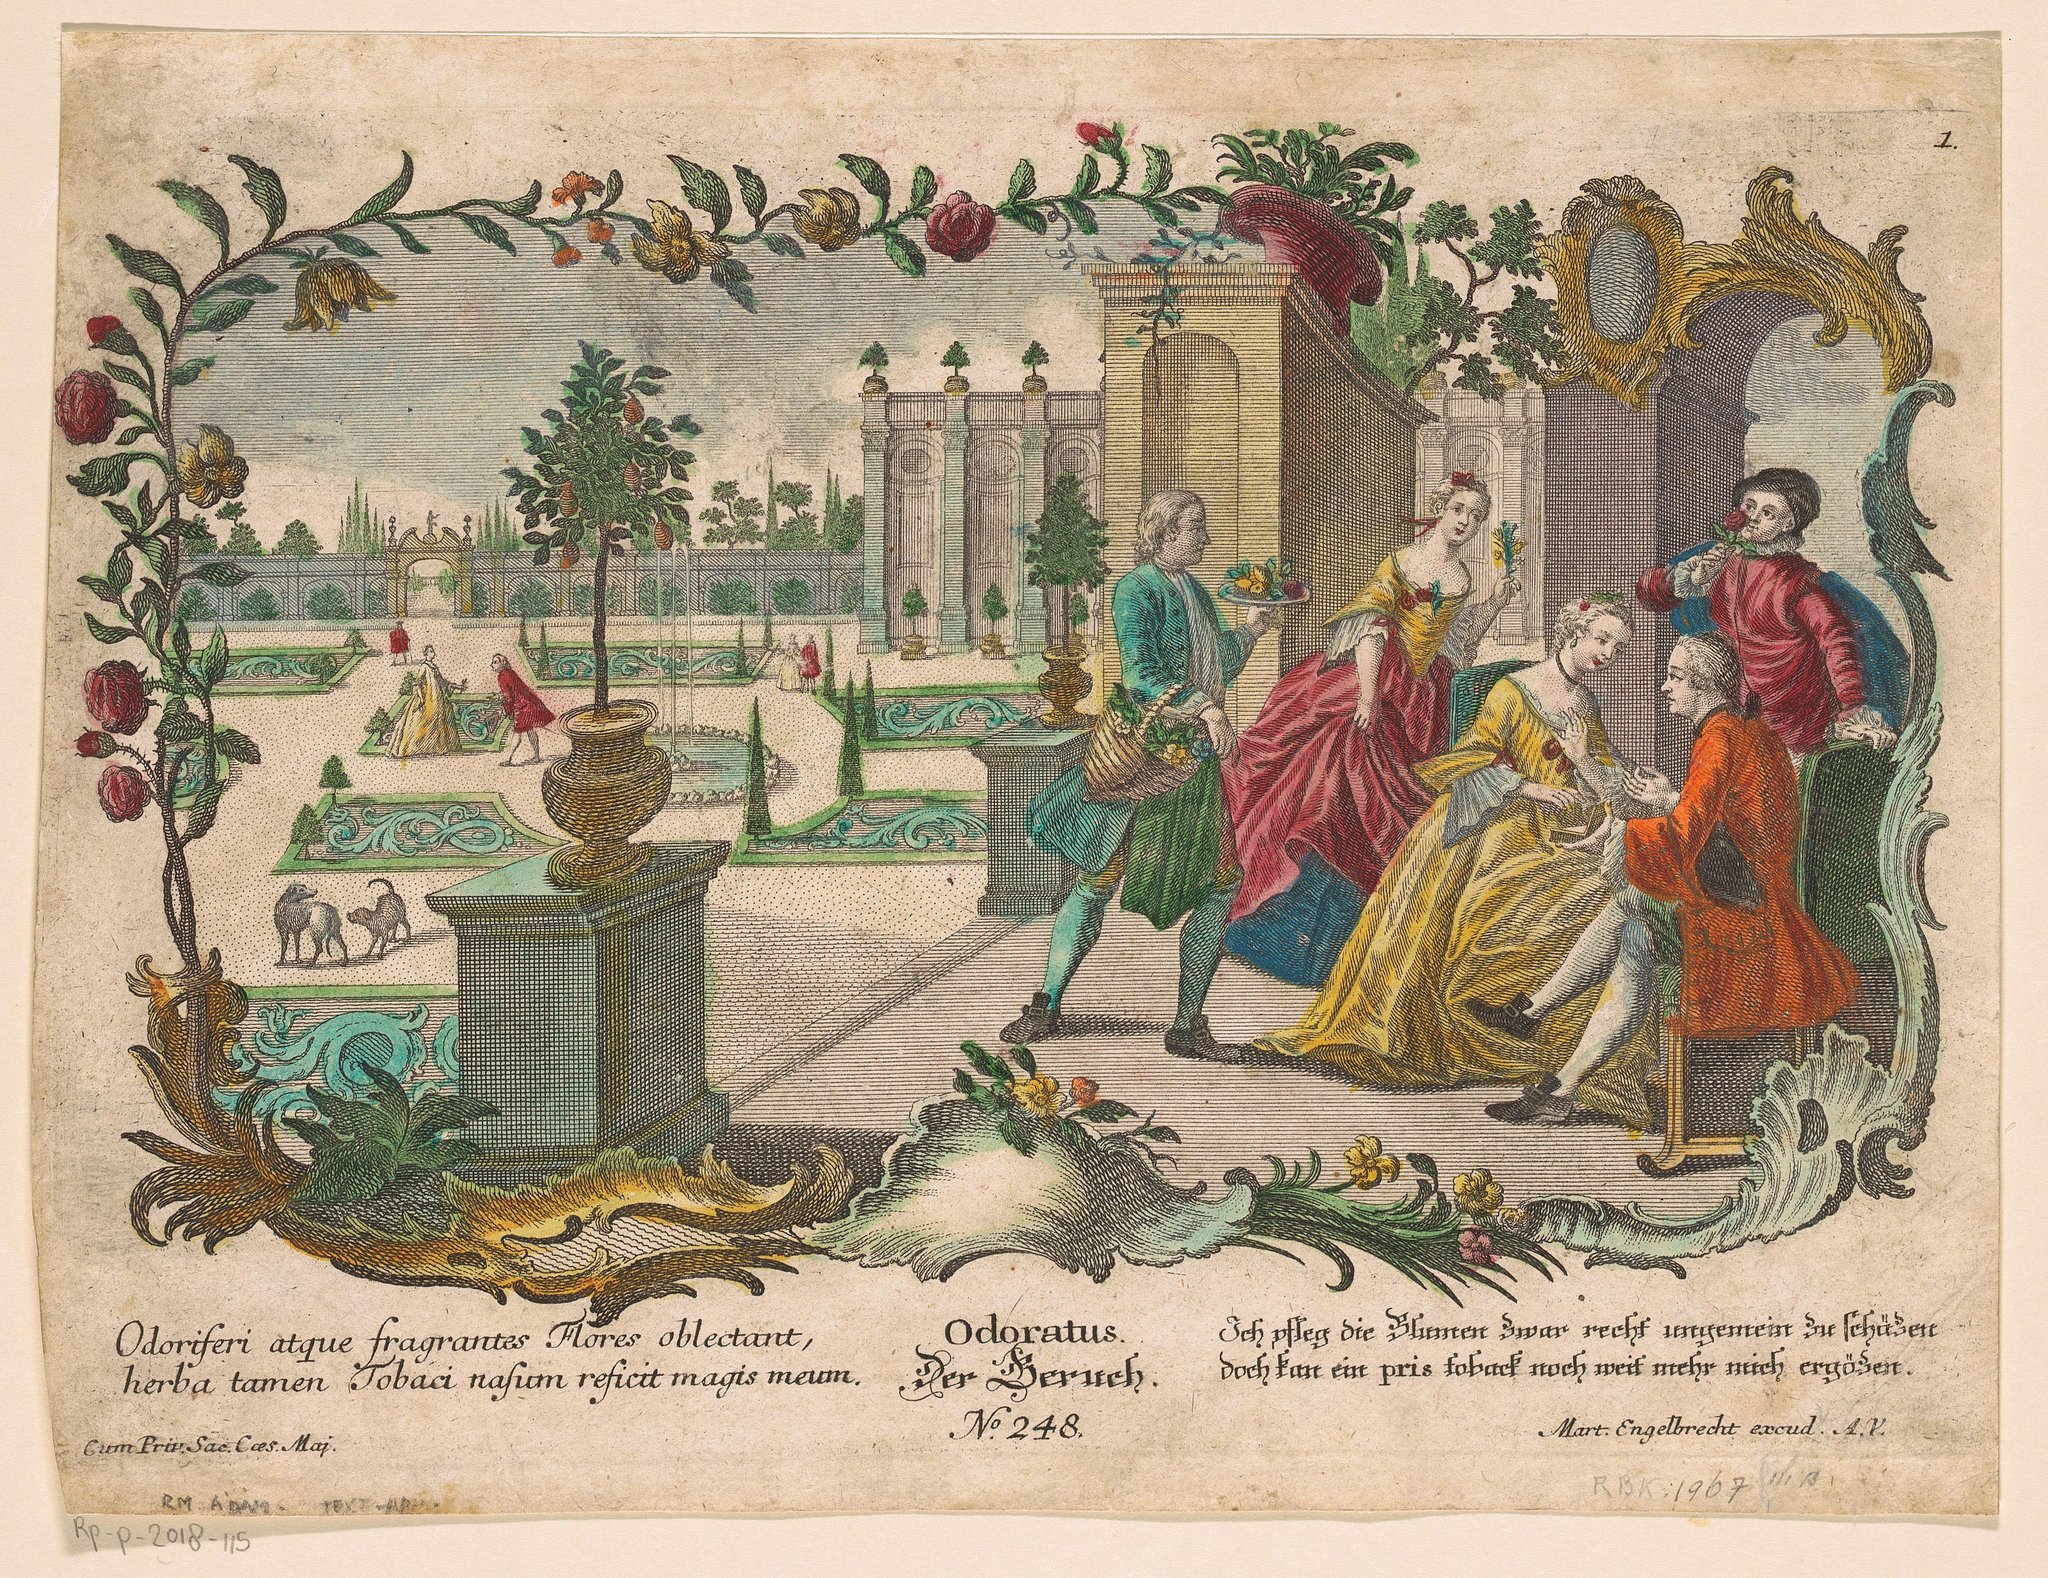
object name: print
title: De vijf zintuigen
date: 1684-1756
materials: paper, watercolor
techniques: engraving, etching, hand coloring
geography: augsburg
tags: flowers, rocaille ornament, garden, smell, smelling (one of the five senses), fruits, dog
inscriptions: collector's mark: Lugt 2228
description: Onder genummerd: No. 248. Met onderschrift in het Latijn en het Duits.